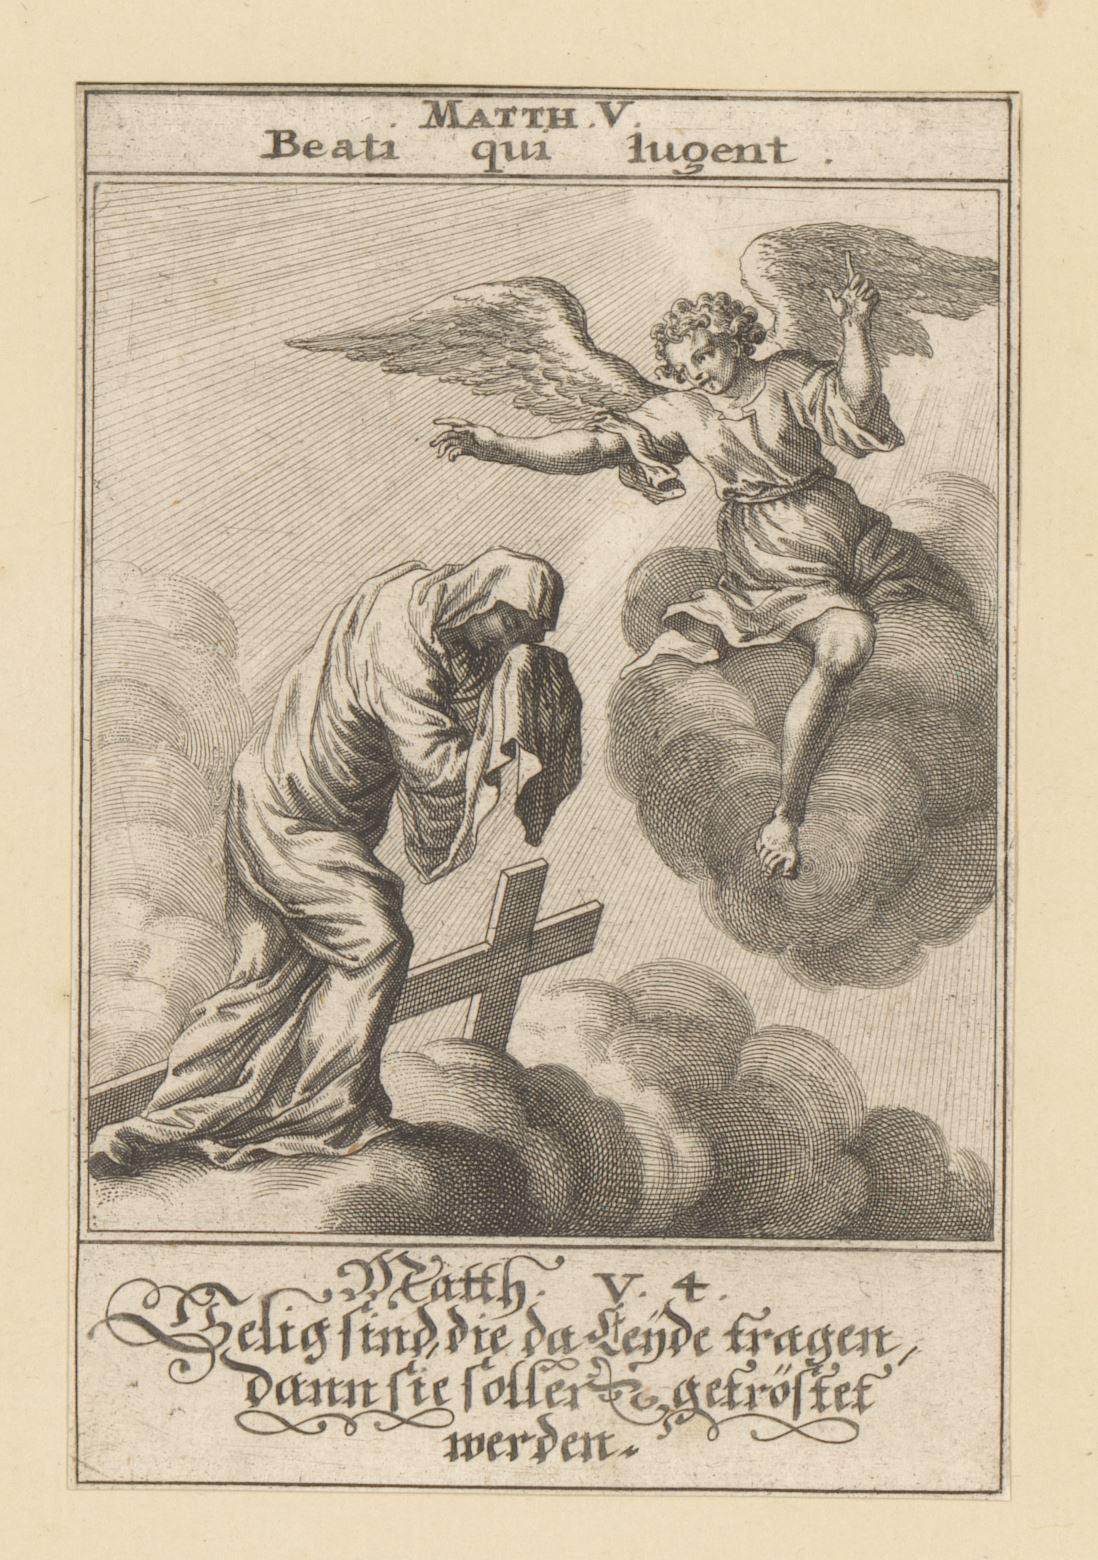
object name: print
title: Gelukkig de treurenden, want zij zullen getroost worden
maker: Anonymous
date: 1697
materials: paper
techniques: etching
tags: blessed are those who mourn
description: Prent ook gebruikt in: Biblia ectypa : Bildnussen auss Heiliger Schrifft. Regensburg: Chr. Wiegel, 1697.